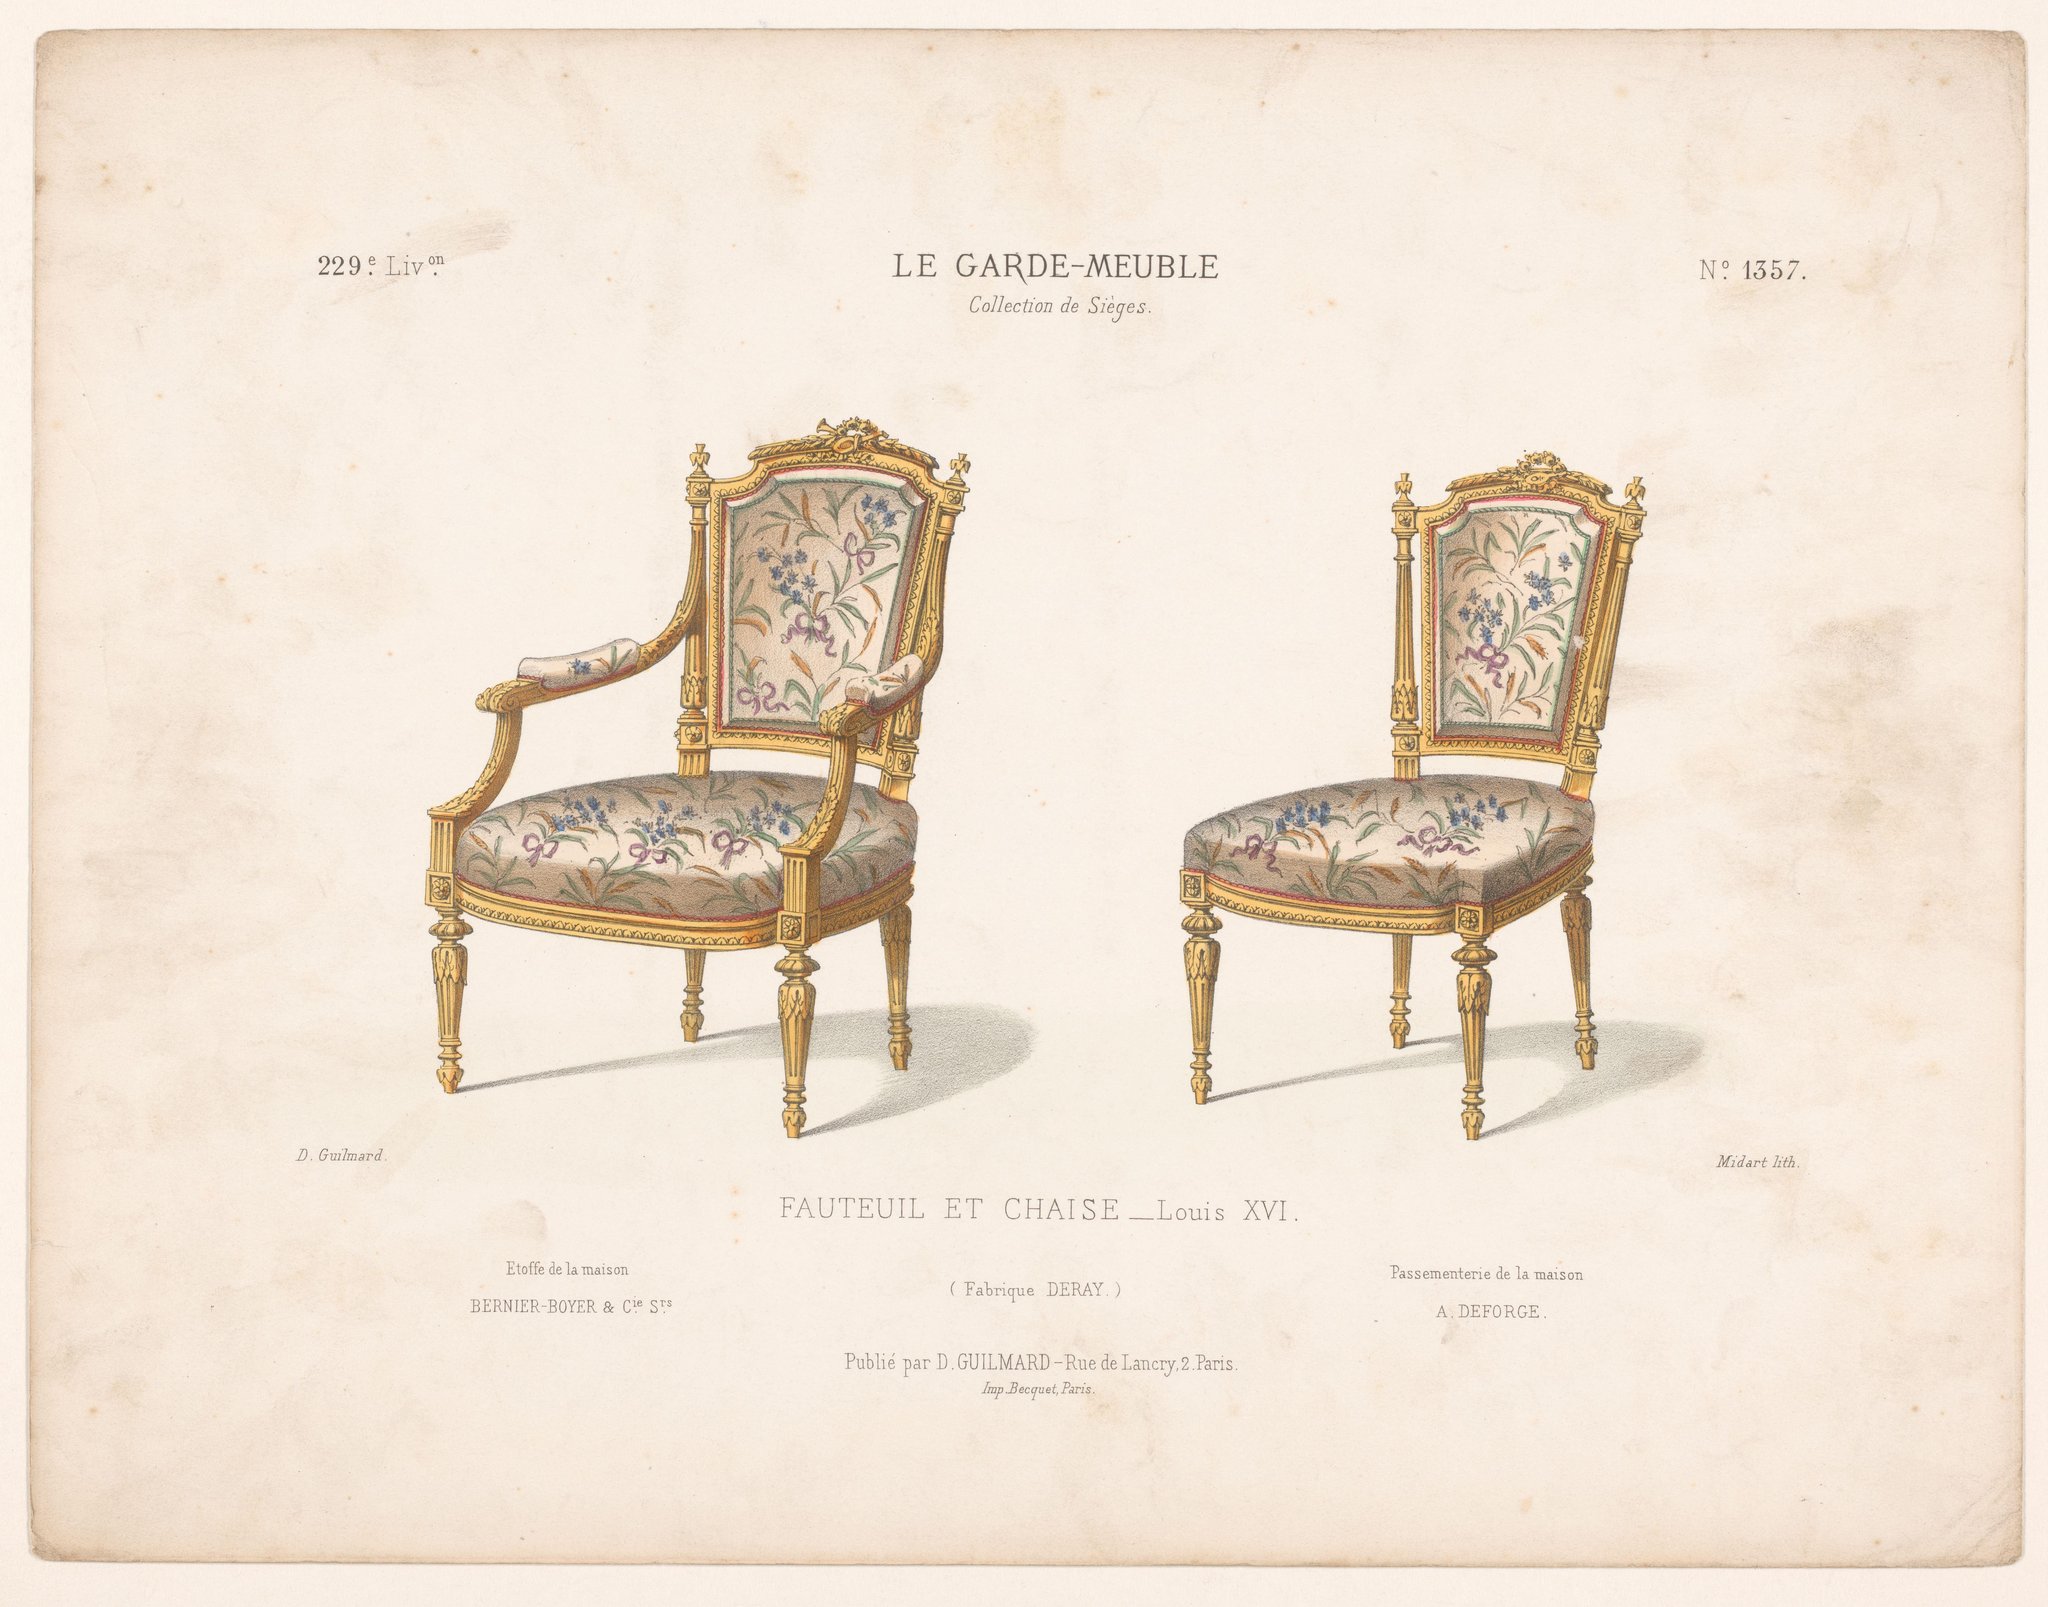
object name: print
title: Fauteuil en stoel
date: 1839-1885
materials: paper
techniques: hand coloring, lithograph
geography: paris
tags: seating furniture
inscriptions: stamp: ‘H.F. Jansen en Zn’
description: Ieder Livraison in de serie Le Garde-Meuble bevat negen platen: drie 'sièges' (zitmeubels), drie 'meubles' (diverse meubels zoals tafels en kasten) en drie 'tentures' (gordijnen en draperieën).